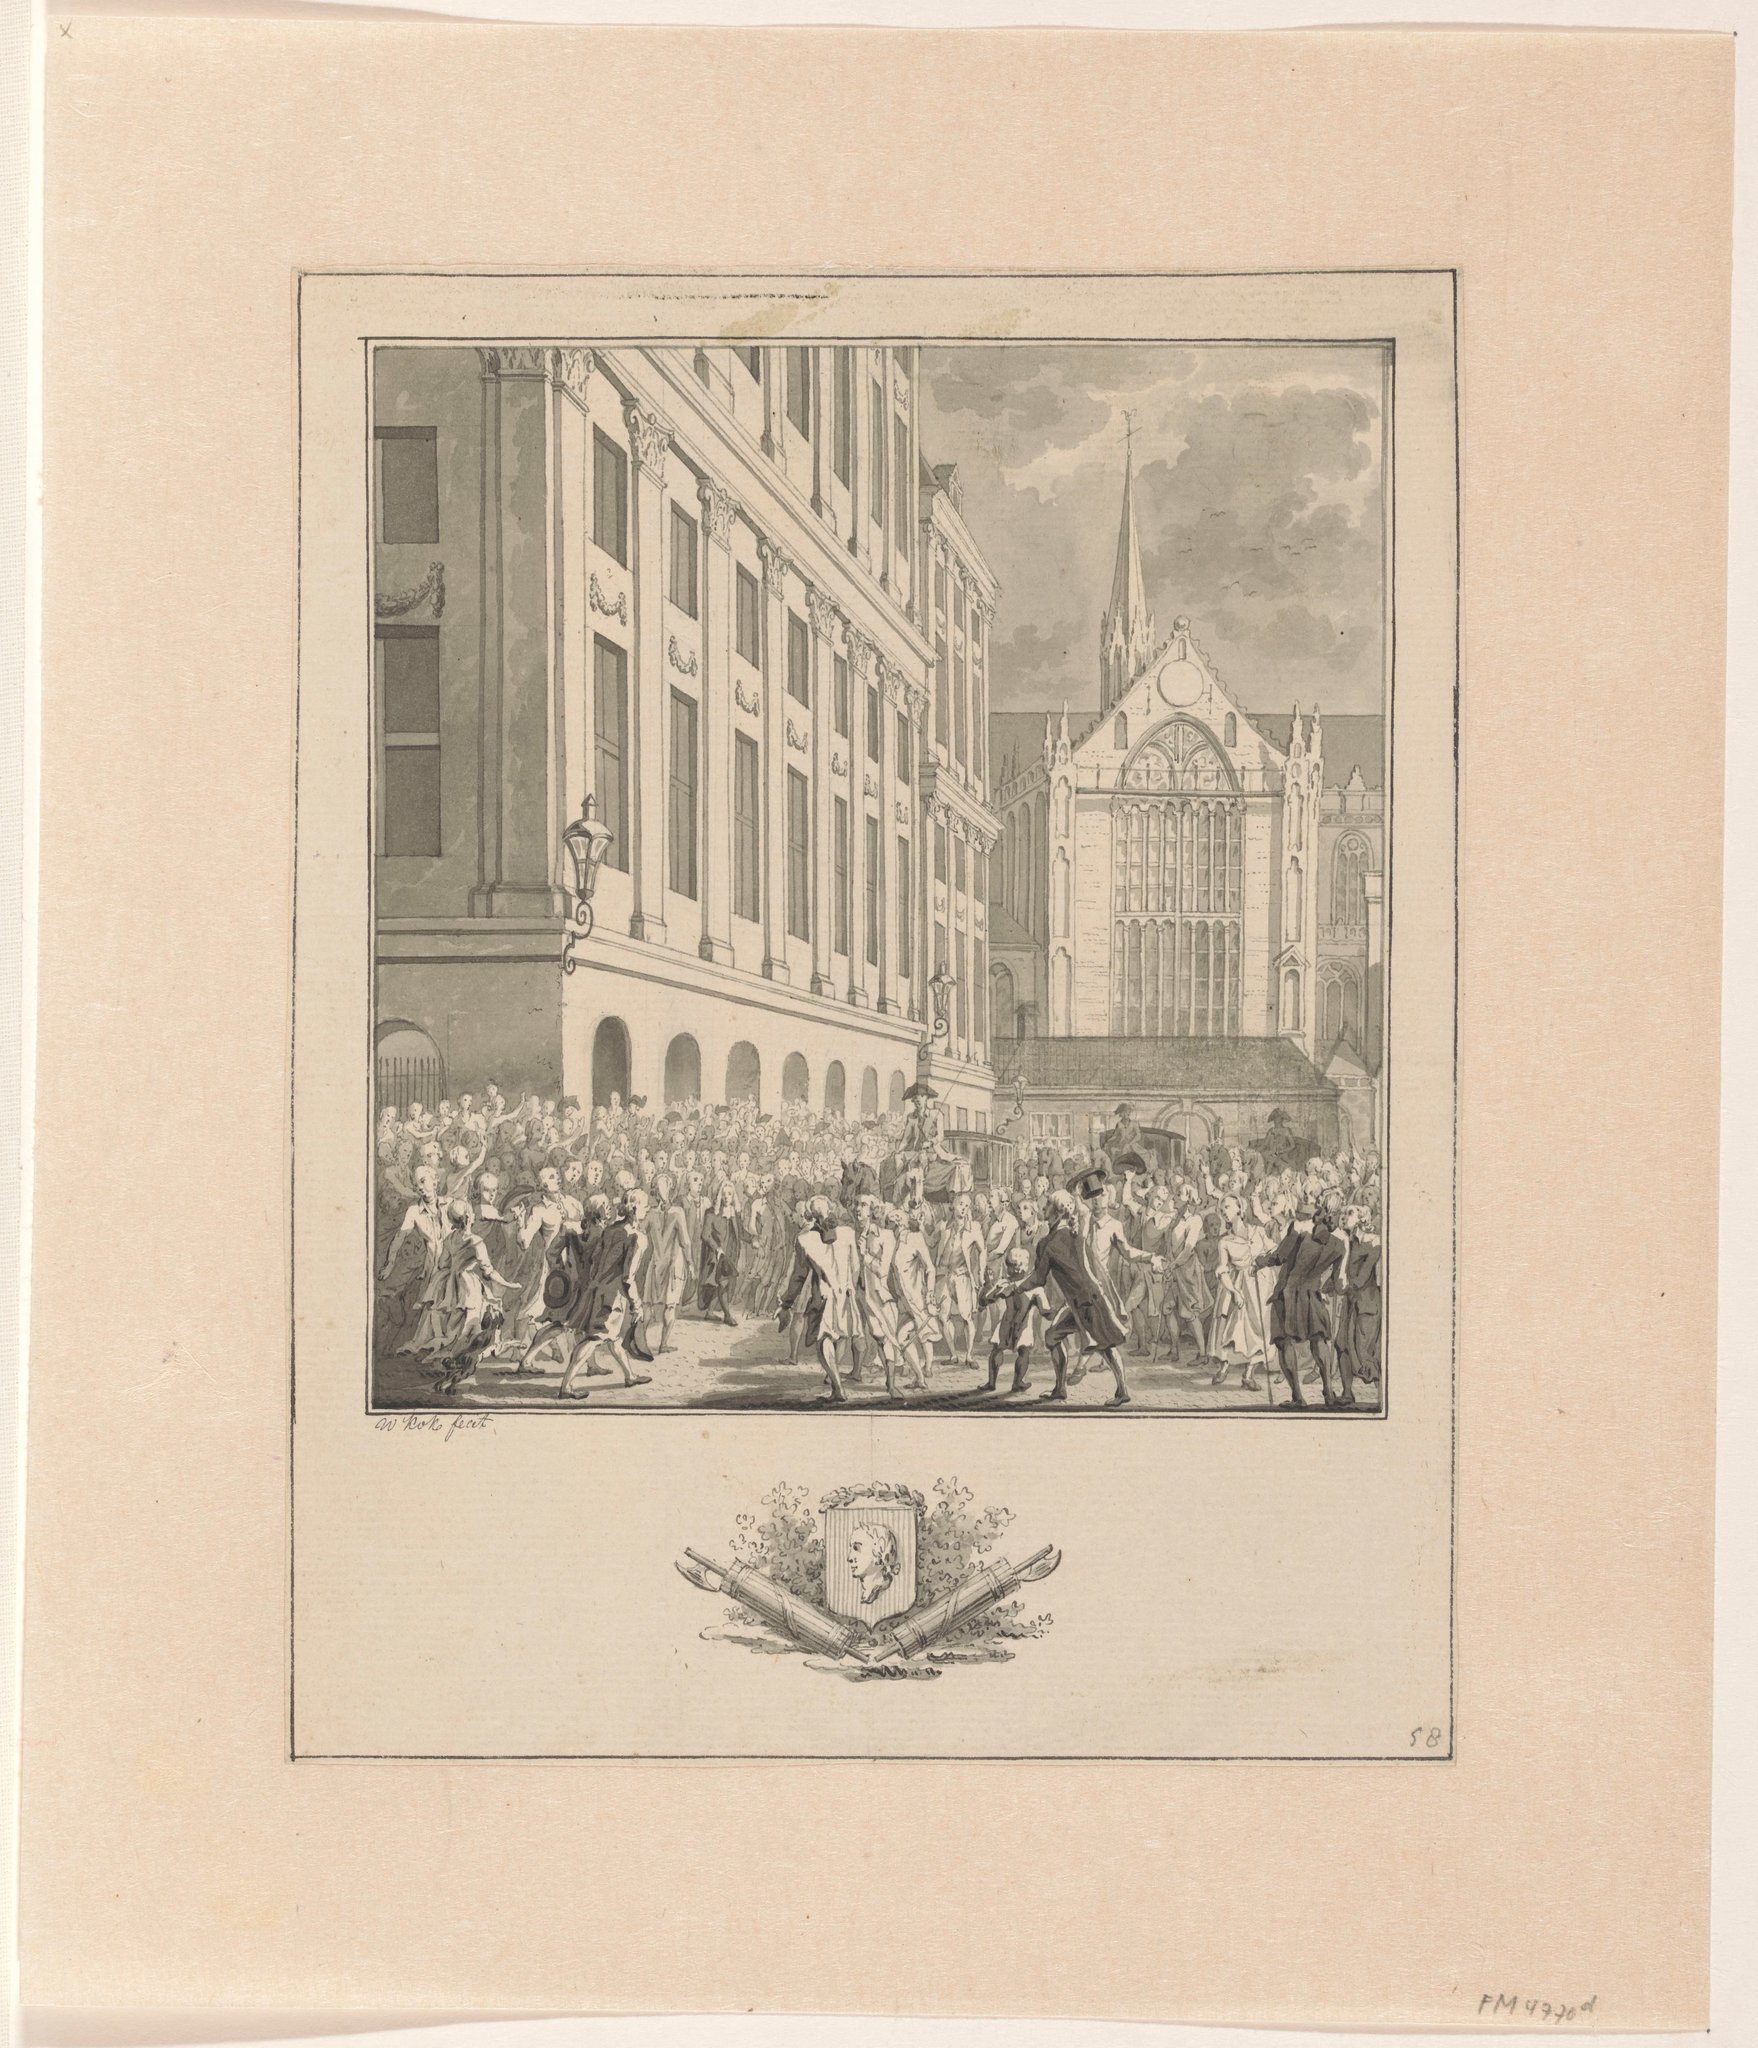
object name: design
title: Toejuiching van Hendrik Danielsz. Hooft op de Dam, 1787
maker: willem kok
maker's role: draughtsman, print maker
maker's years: 1761-1807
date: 1787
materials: paper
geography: northern netherlands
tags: amsterdam, mayor, hendrik danielsz. hooft, crowd, mob, mayor, burgomaster, triumphal entry and public reception, pageant, 'entrée solennelle', 'joyeuse entrée', patriots (1780-1795)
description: De Amsterdamse burgemeester Hendrik Danielsz. Hooft wordt bij vertrek in zijn rijtuig toegejuicht door het publiek op de Dam, 26 februari 1787. In de marge het wapen van Hooft met twee pijlenbundels. Ontwerp voor een prent.